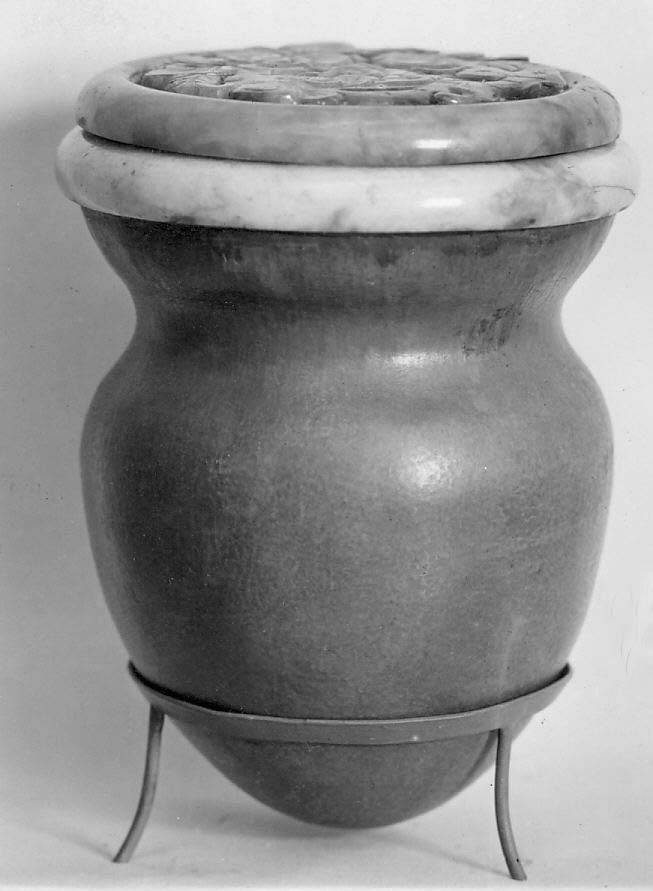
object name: cricket cage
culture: chinese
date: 1701-1900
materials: jade